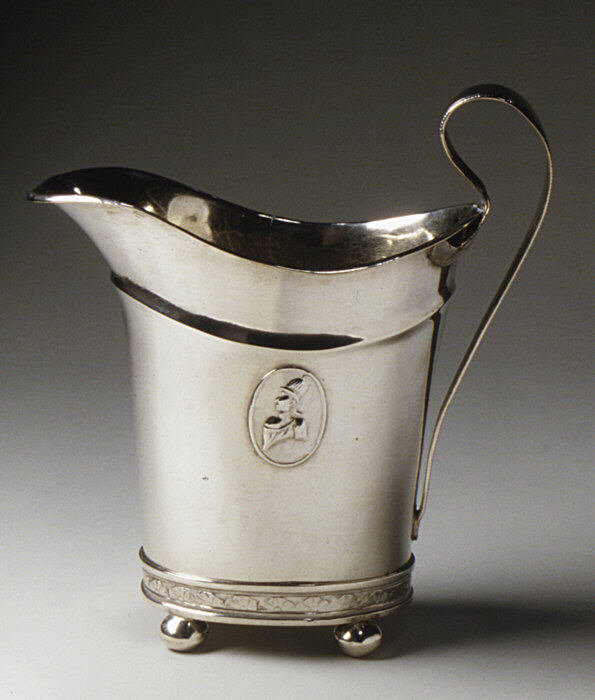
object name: creamer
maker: jacob frederic granander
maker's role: maker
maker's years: 1802-1831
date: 1801-1833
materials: silver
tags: men,profiles